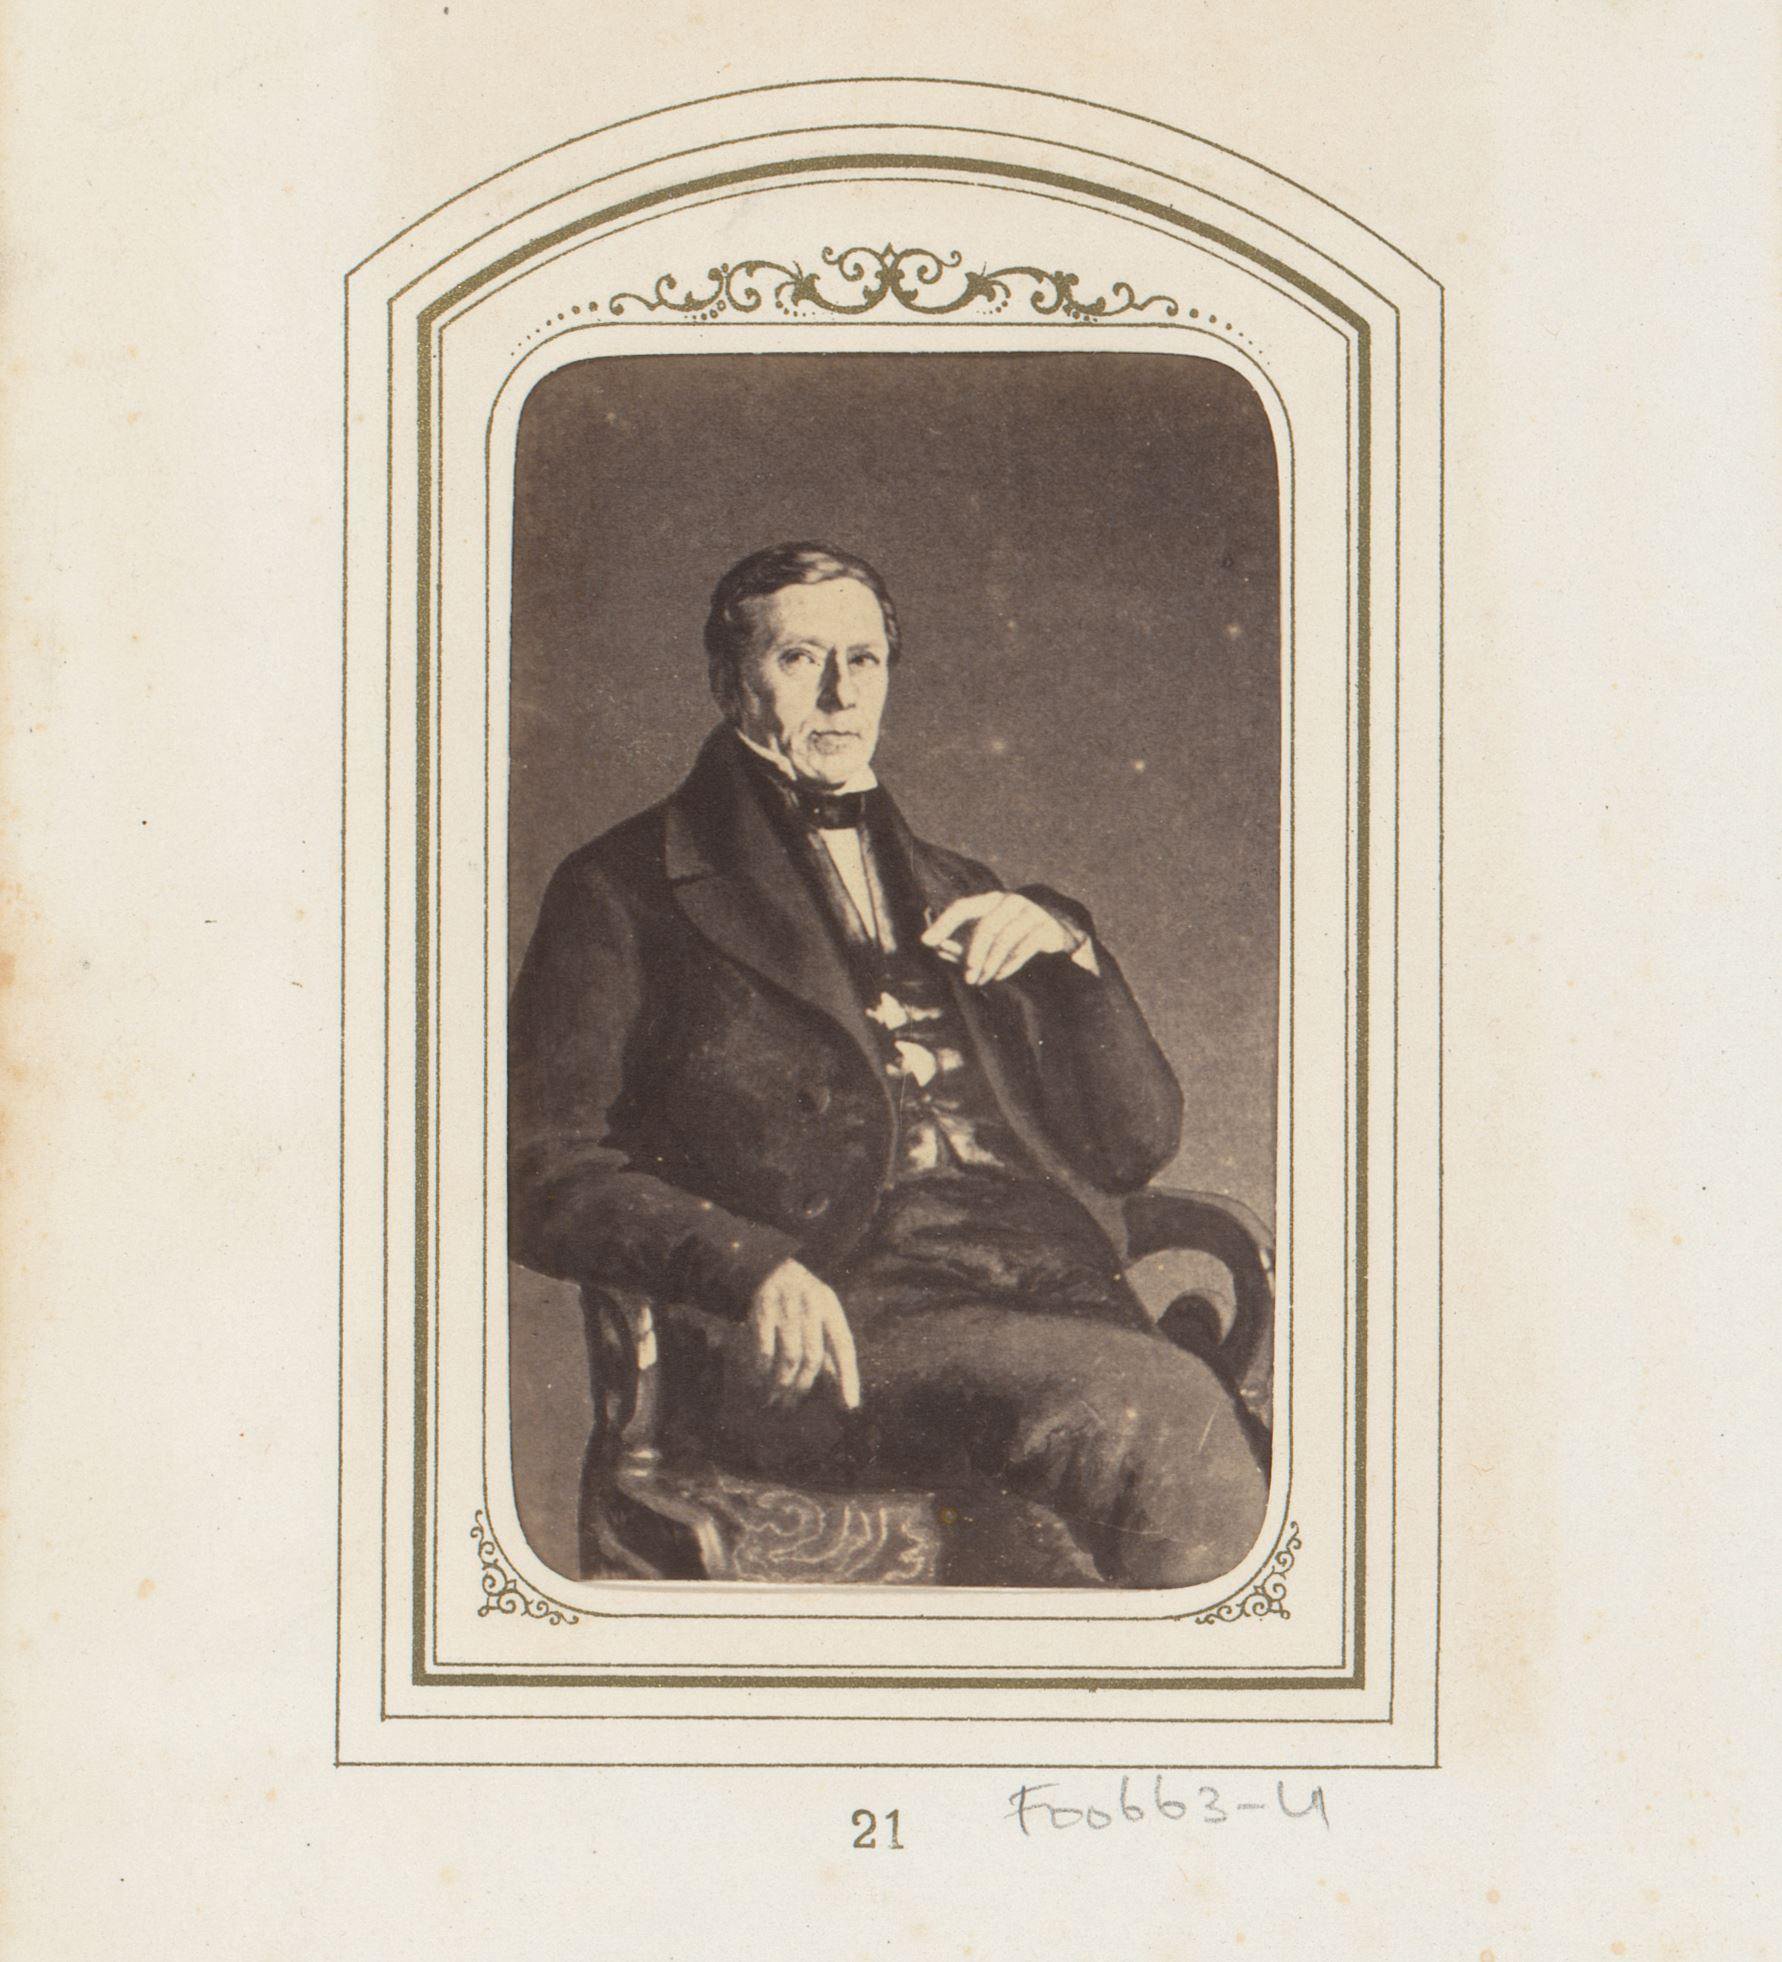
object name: carte de visite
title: Portret van een zittende man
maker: hermanus siderius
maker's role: draughtsman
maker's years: 1819-1892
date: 1860-1880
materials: cardboard, photographic support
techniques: albumen print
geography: harlingen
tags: historical persons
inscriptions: number: ‘21’, inscription: ‘H. Siderius/ Harlingen’